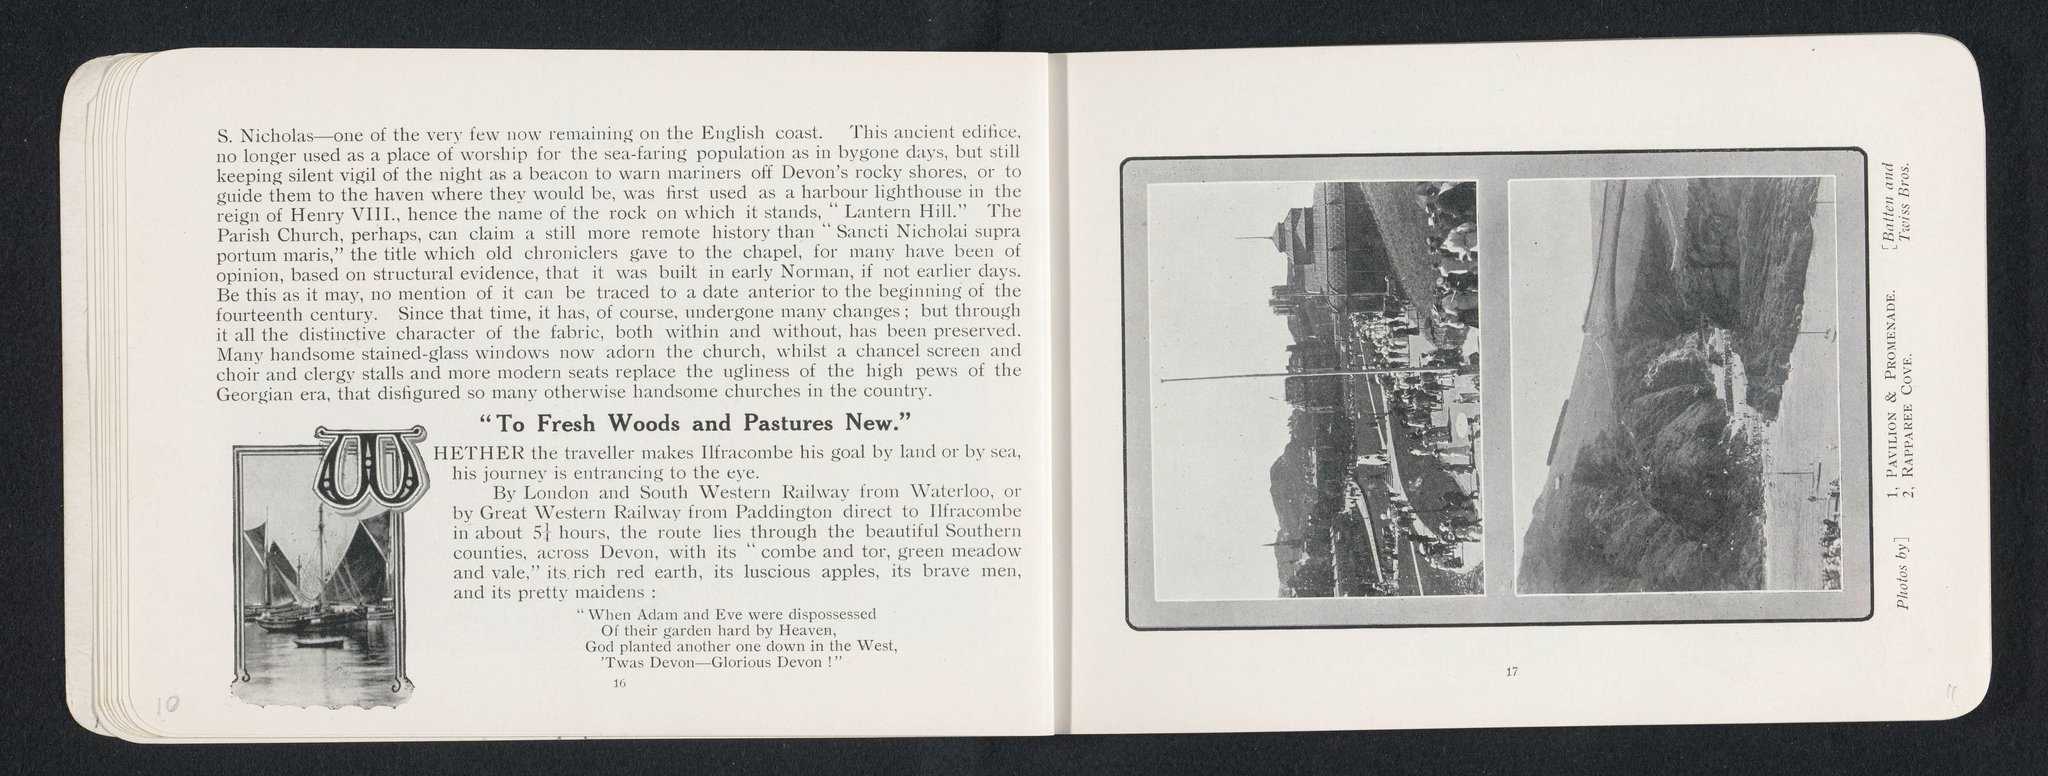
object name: page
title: Gezicht op de promenade van Ilfracombe en een gezicht op Rapparee Cove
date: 1900-1920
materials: paper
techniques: autotype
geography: ilfracombe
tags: cape (coast), avenue, boulevard, promenade, esplanade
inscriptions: inscription: ‘1, Pavillion & Promenade. 2, Rapparee Cove’